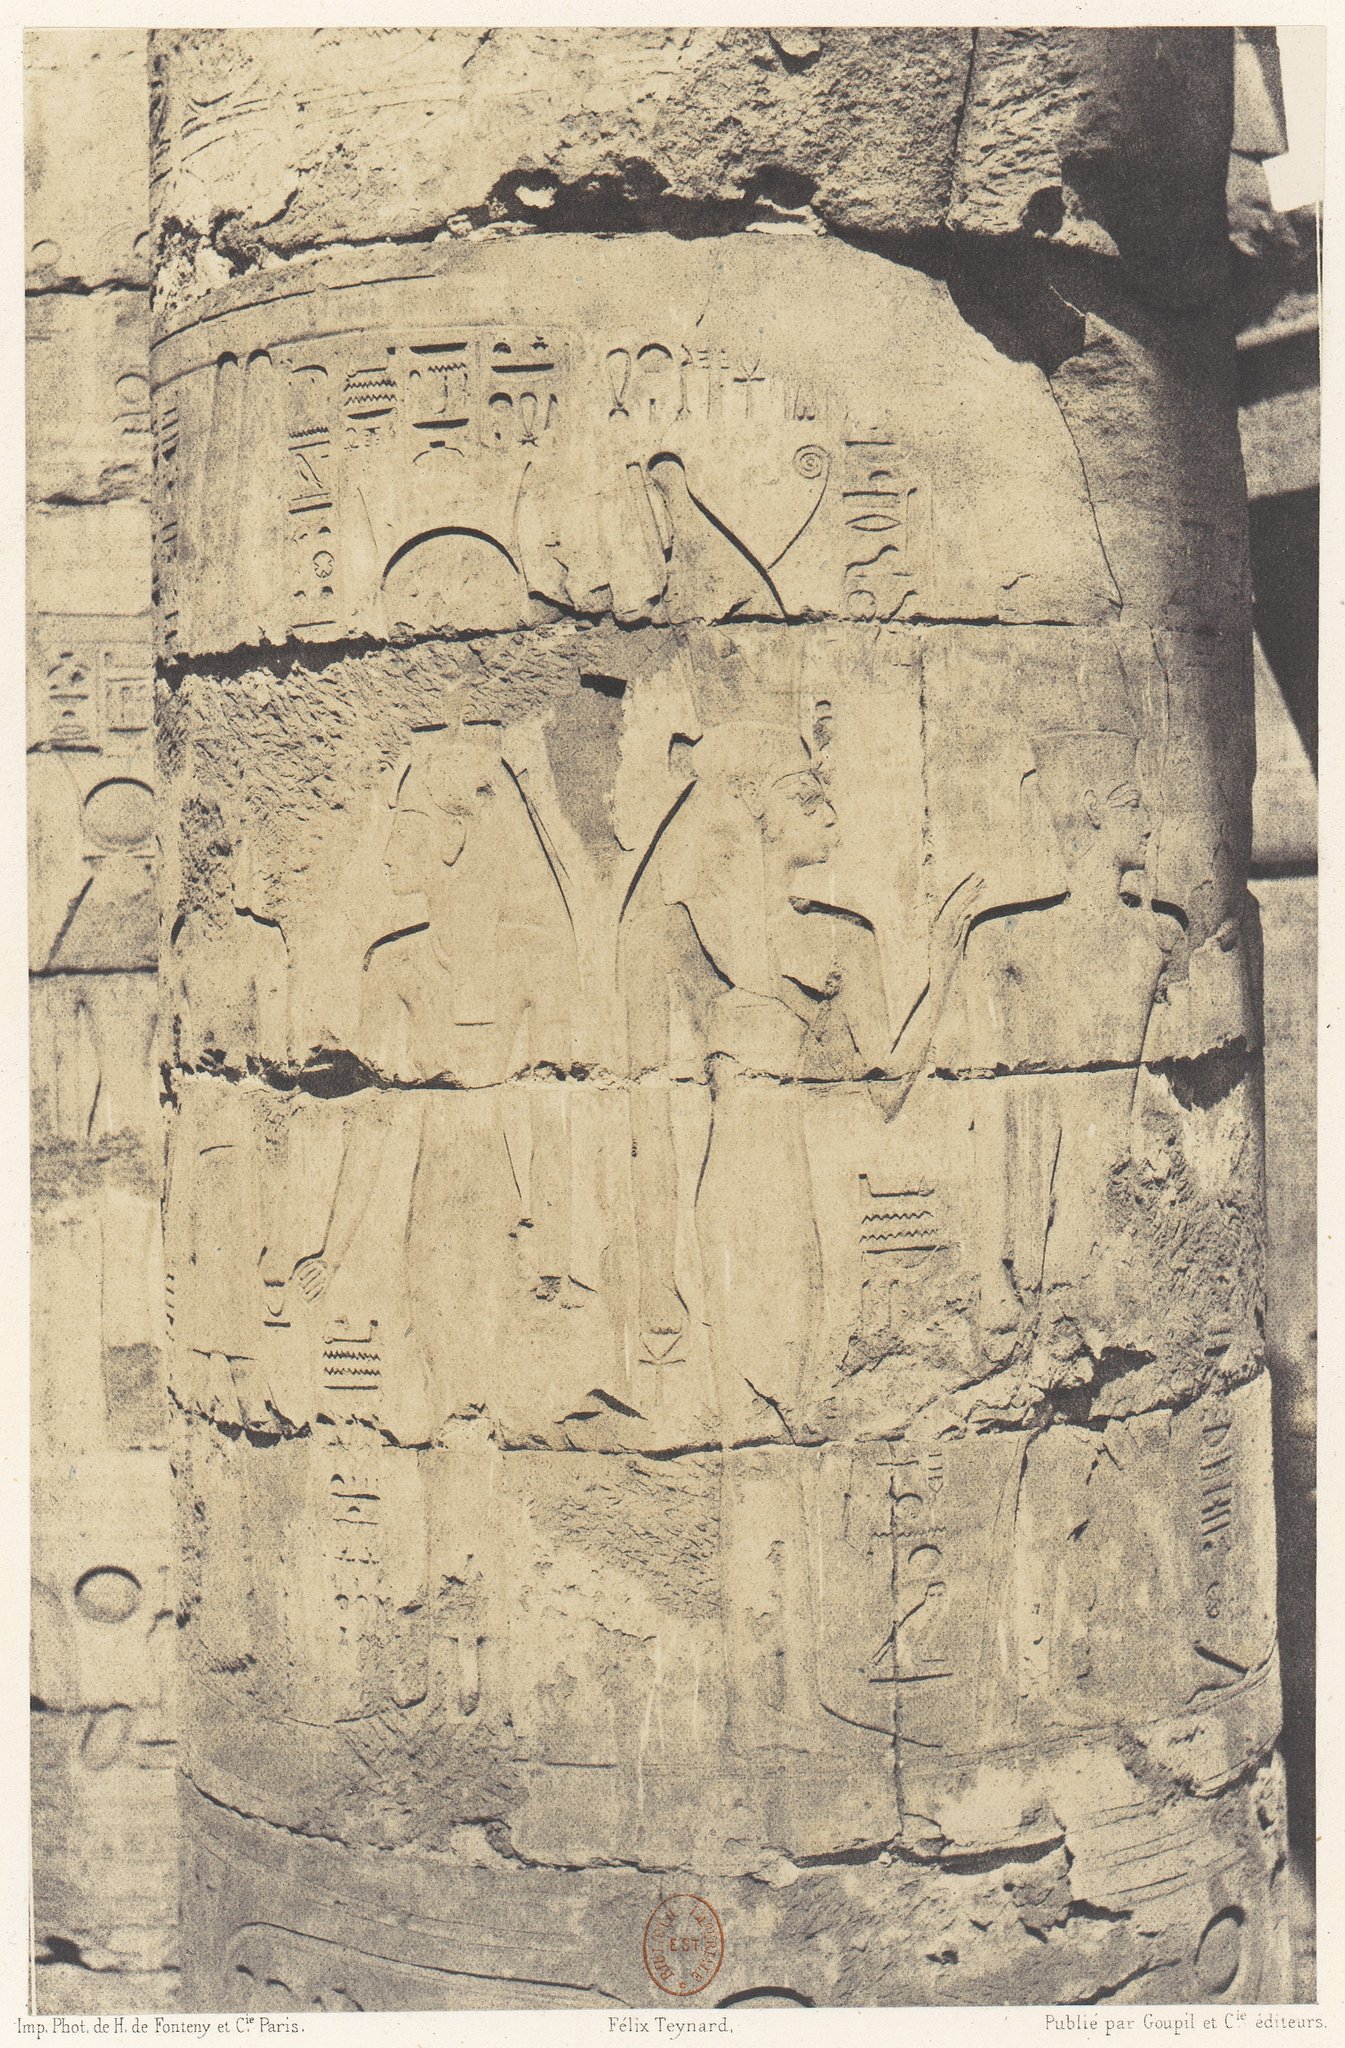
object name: photograph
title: Karnak (Thèbes), Palais - Salle Hypostyle - Colonnade Centrale - Décoration d'un Fut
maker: félix teynard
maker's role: artist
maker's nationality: french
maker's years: 1817-1892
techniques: paper negative, salted paper print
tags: architecture,hieroglyphs